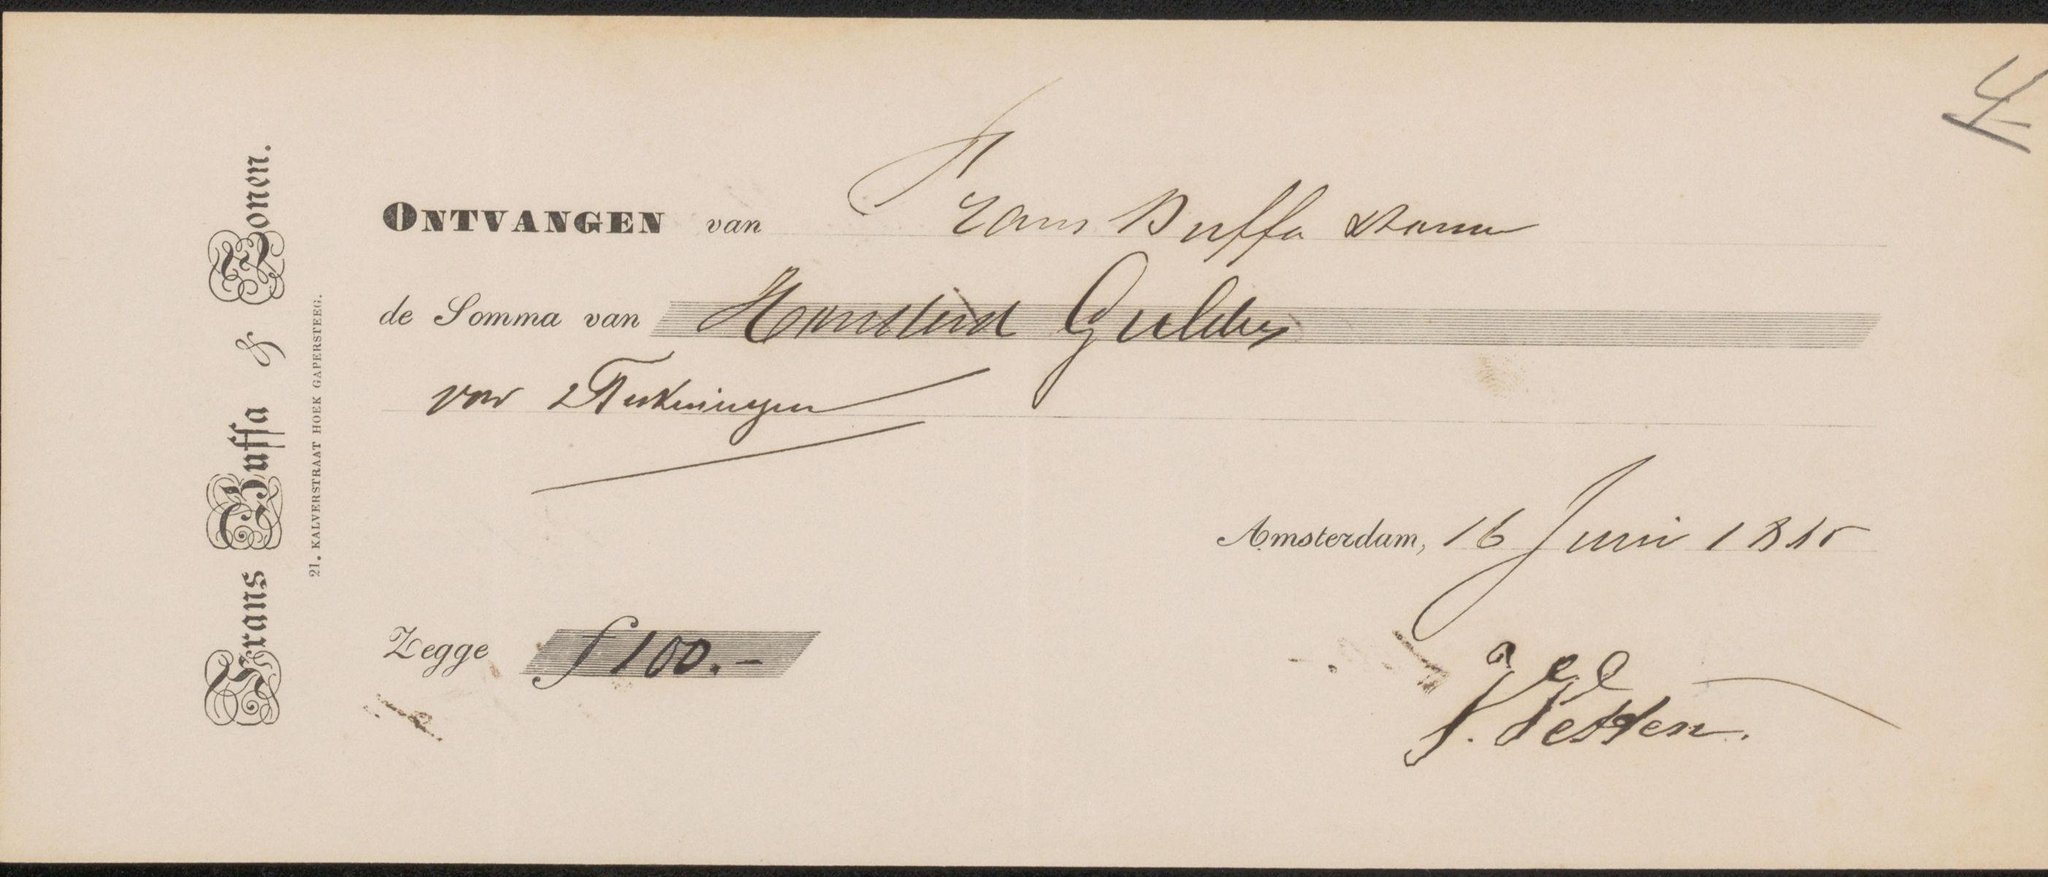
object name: ontvangstbewijs, kwitantie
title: Kwitantie voor Johannes Vetten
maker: johannes vetten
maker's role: painter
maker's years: 1827-1866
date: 1865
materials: ink, paper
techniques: pen, printing, writing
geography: amsterdam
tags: drawing, money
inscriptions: collector's mark: Lugt 2233